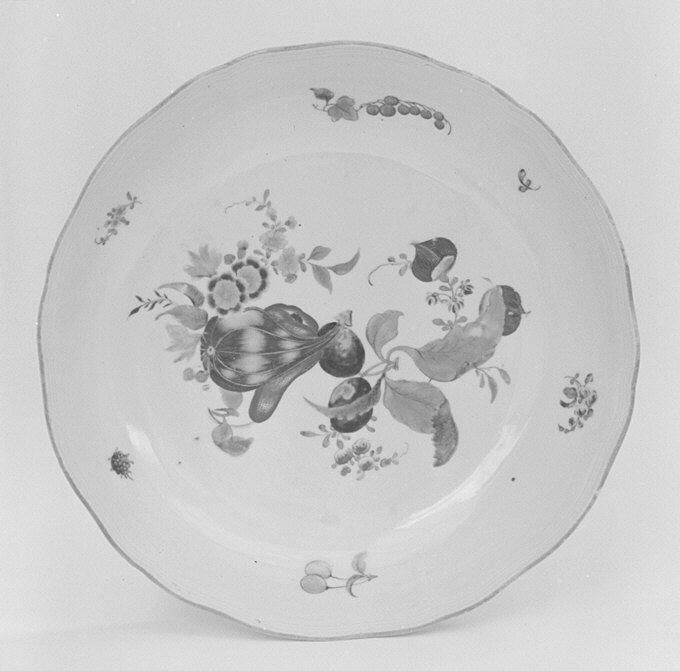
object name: dish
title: Deep dish (part of a service)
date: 1760-1770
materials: hard paste porcelain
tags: flowers